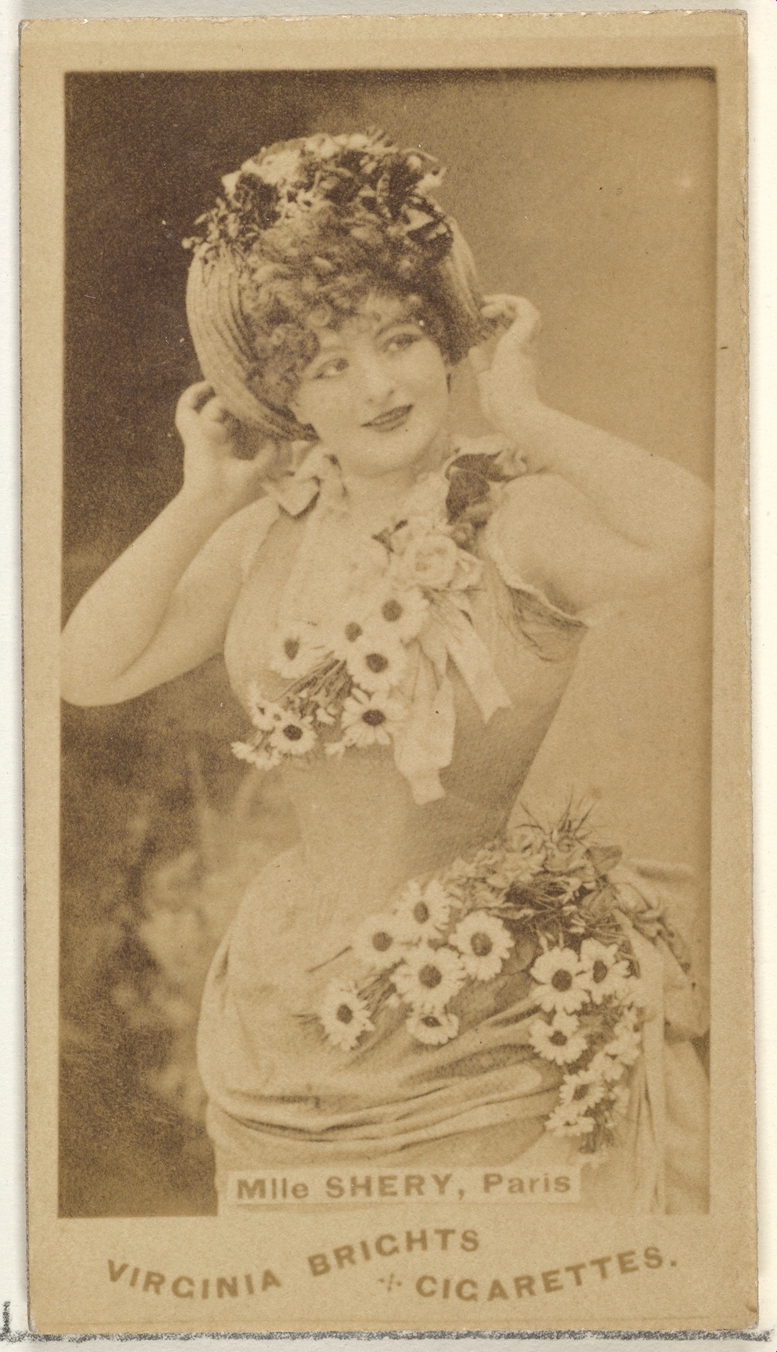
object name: photograph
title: Mlle. Shery, Paris, from the Actors and Actresses series (N45, Type 1) for Virginia Brights Cigarettes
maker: allen & ginter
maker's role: publisher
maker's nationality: american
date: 1888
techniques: albumen silver print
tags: portraits,women,actresses